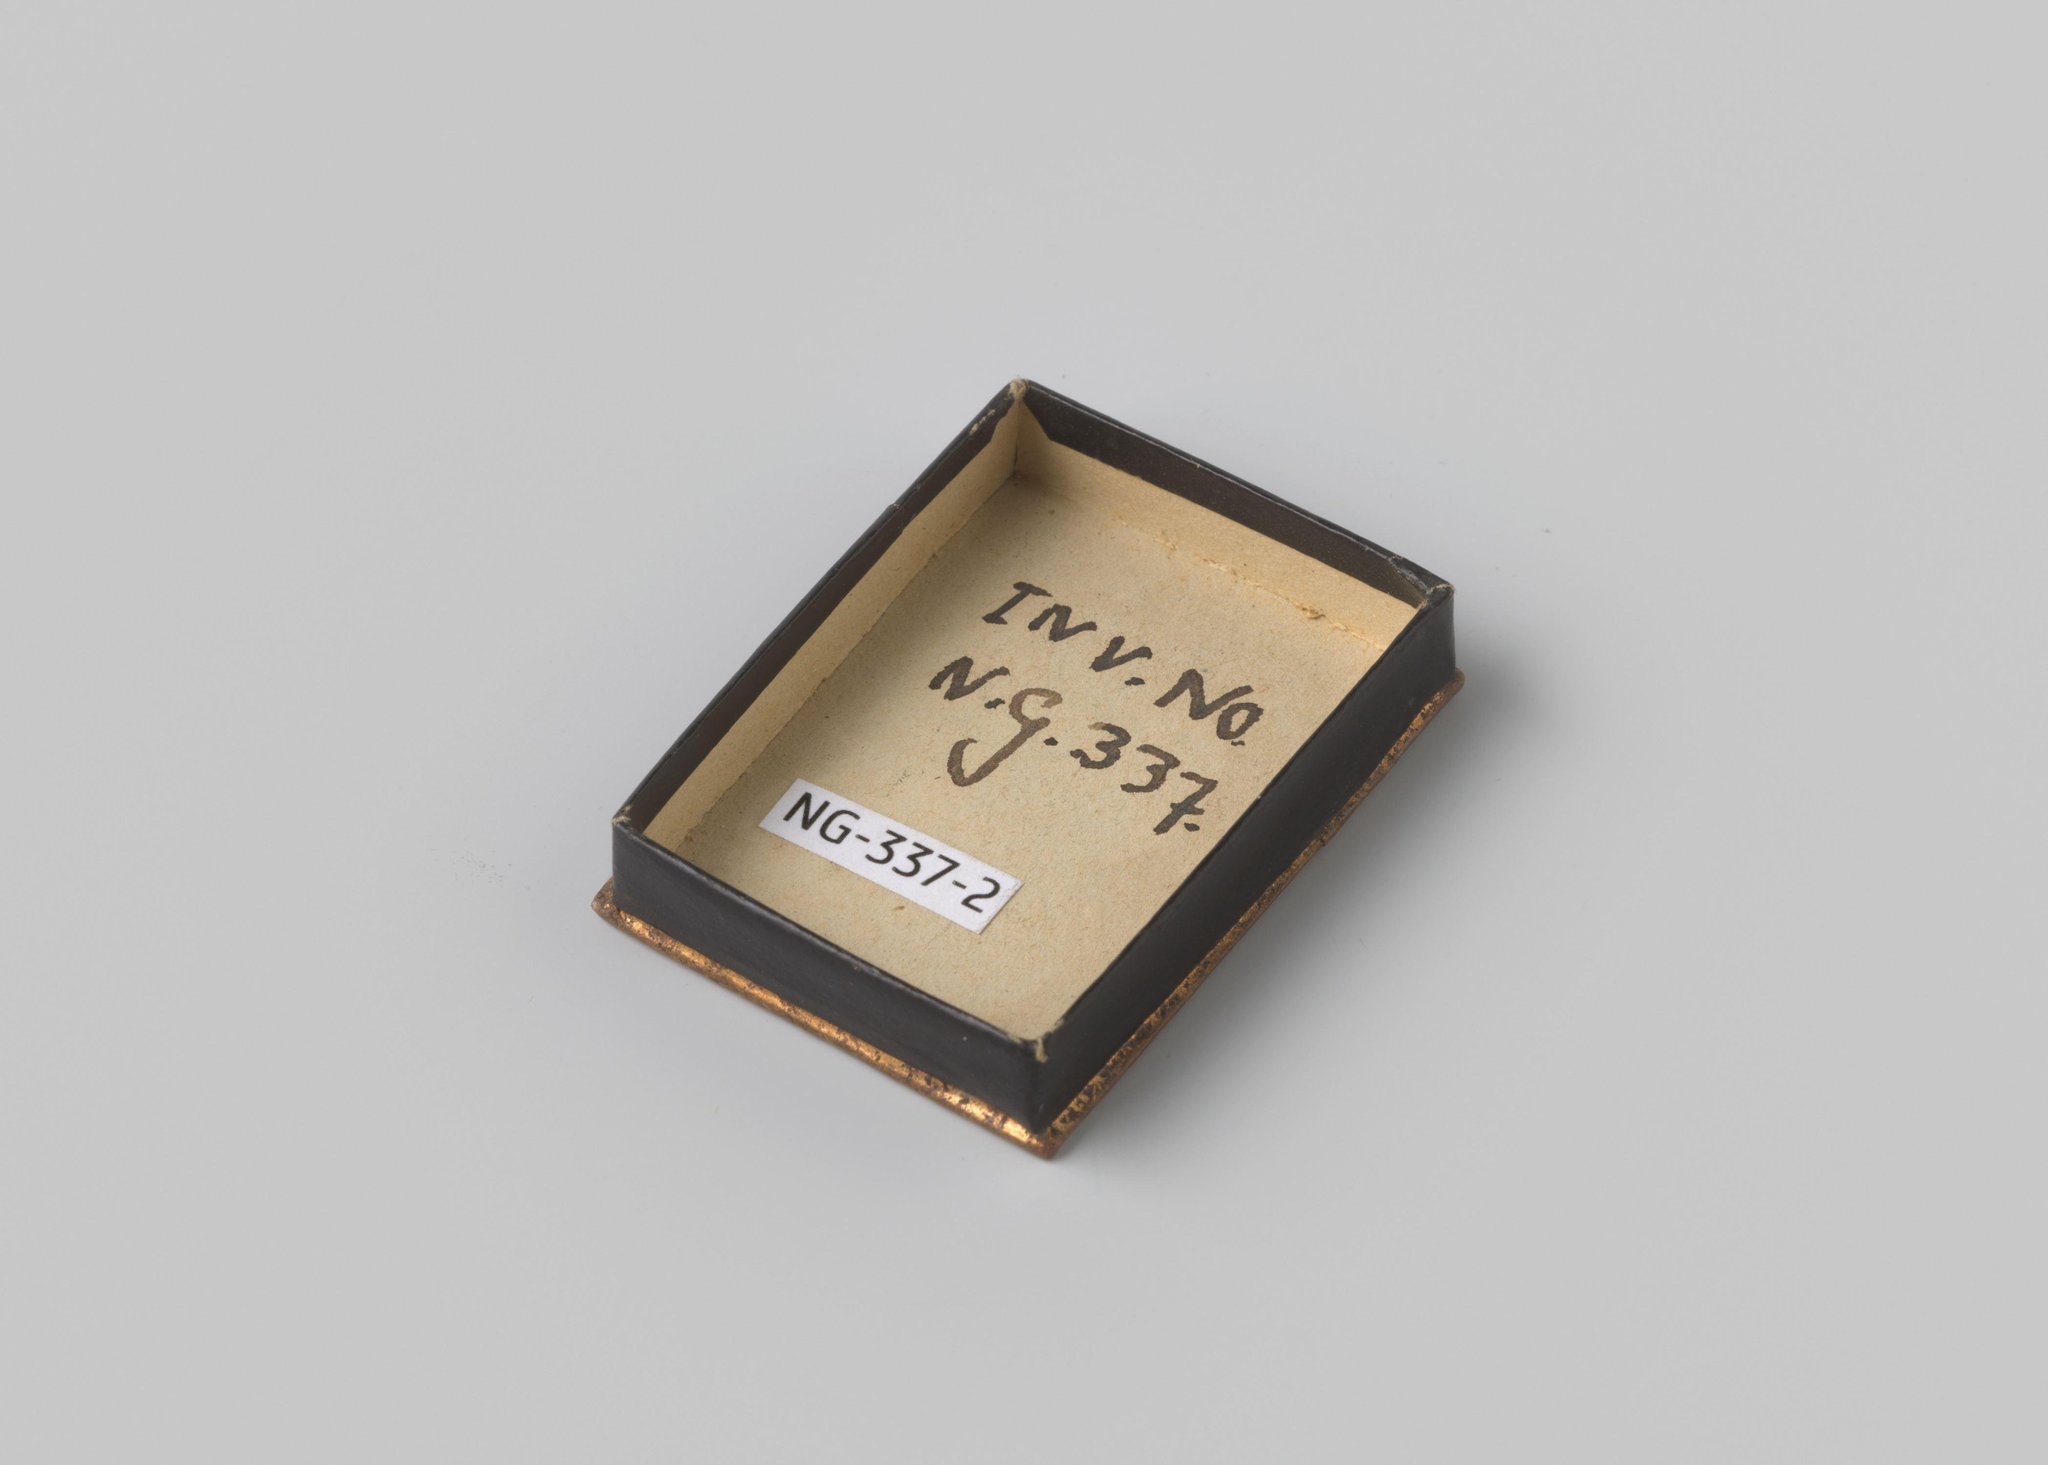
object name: box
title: Onderkant van een doosje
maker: johannes albertus adolf gerritsen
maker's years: 1840-1904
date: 1898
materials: cardboard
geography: amsterdam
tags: the hague, print maker, wilhelmina of the netherlands, netherlands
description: Onderkant van een kartonnen doosje met een goudkleurig randje en een gekroonde W.